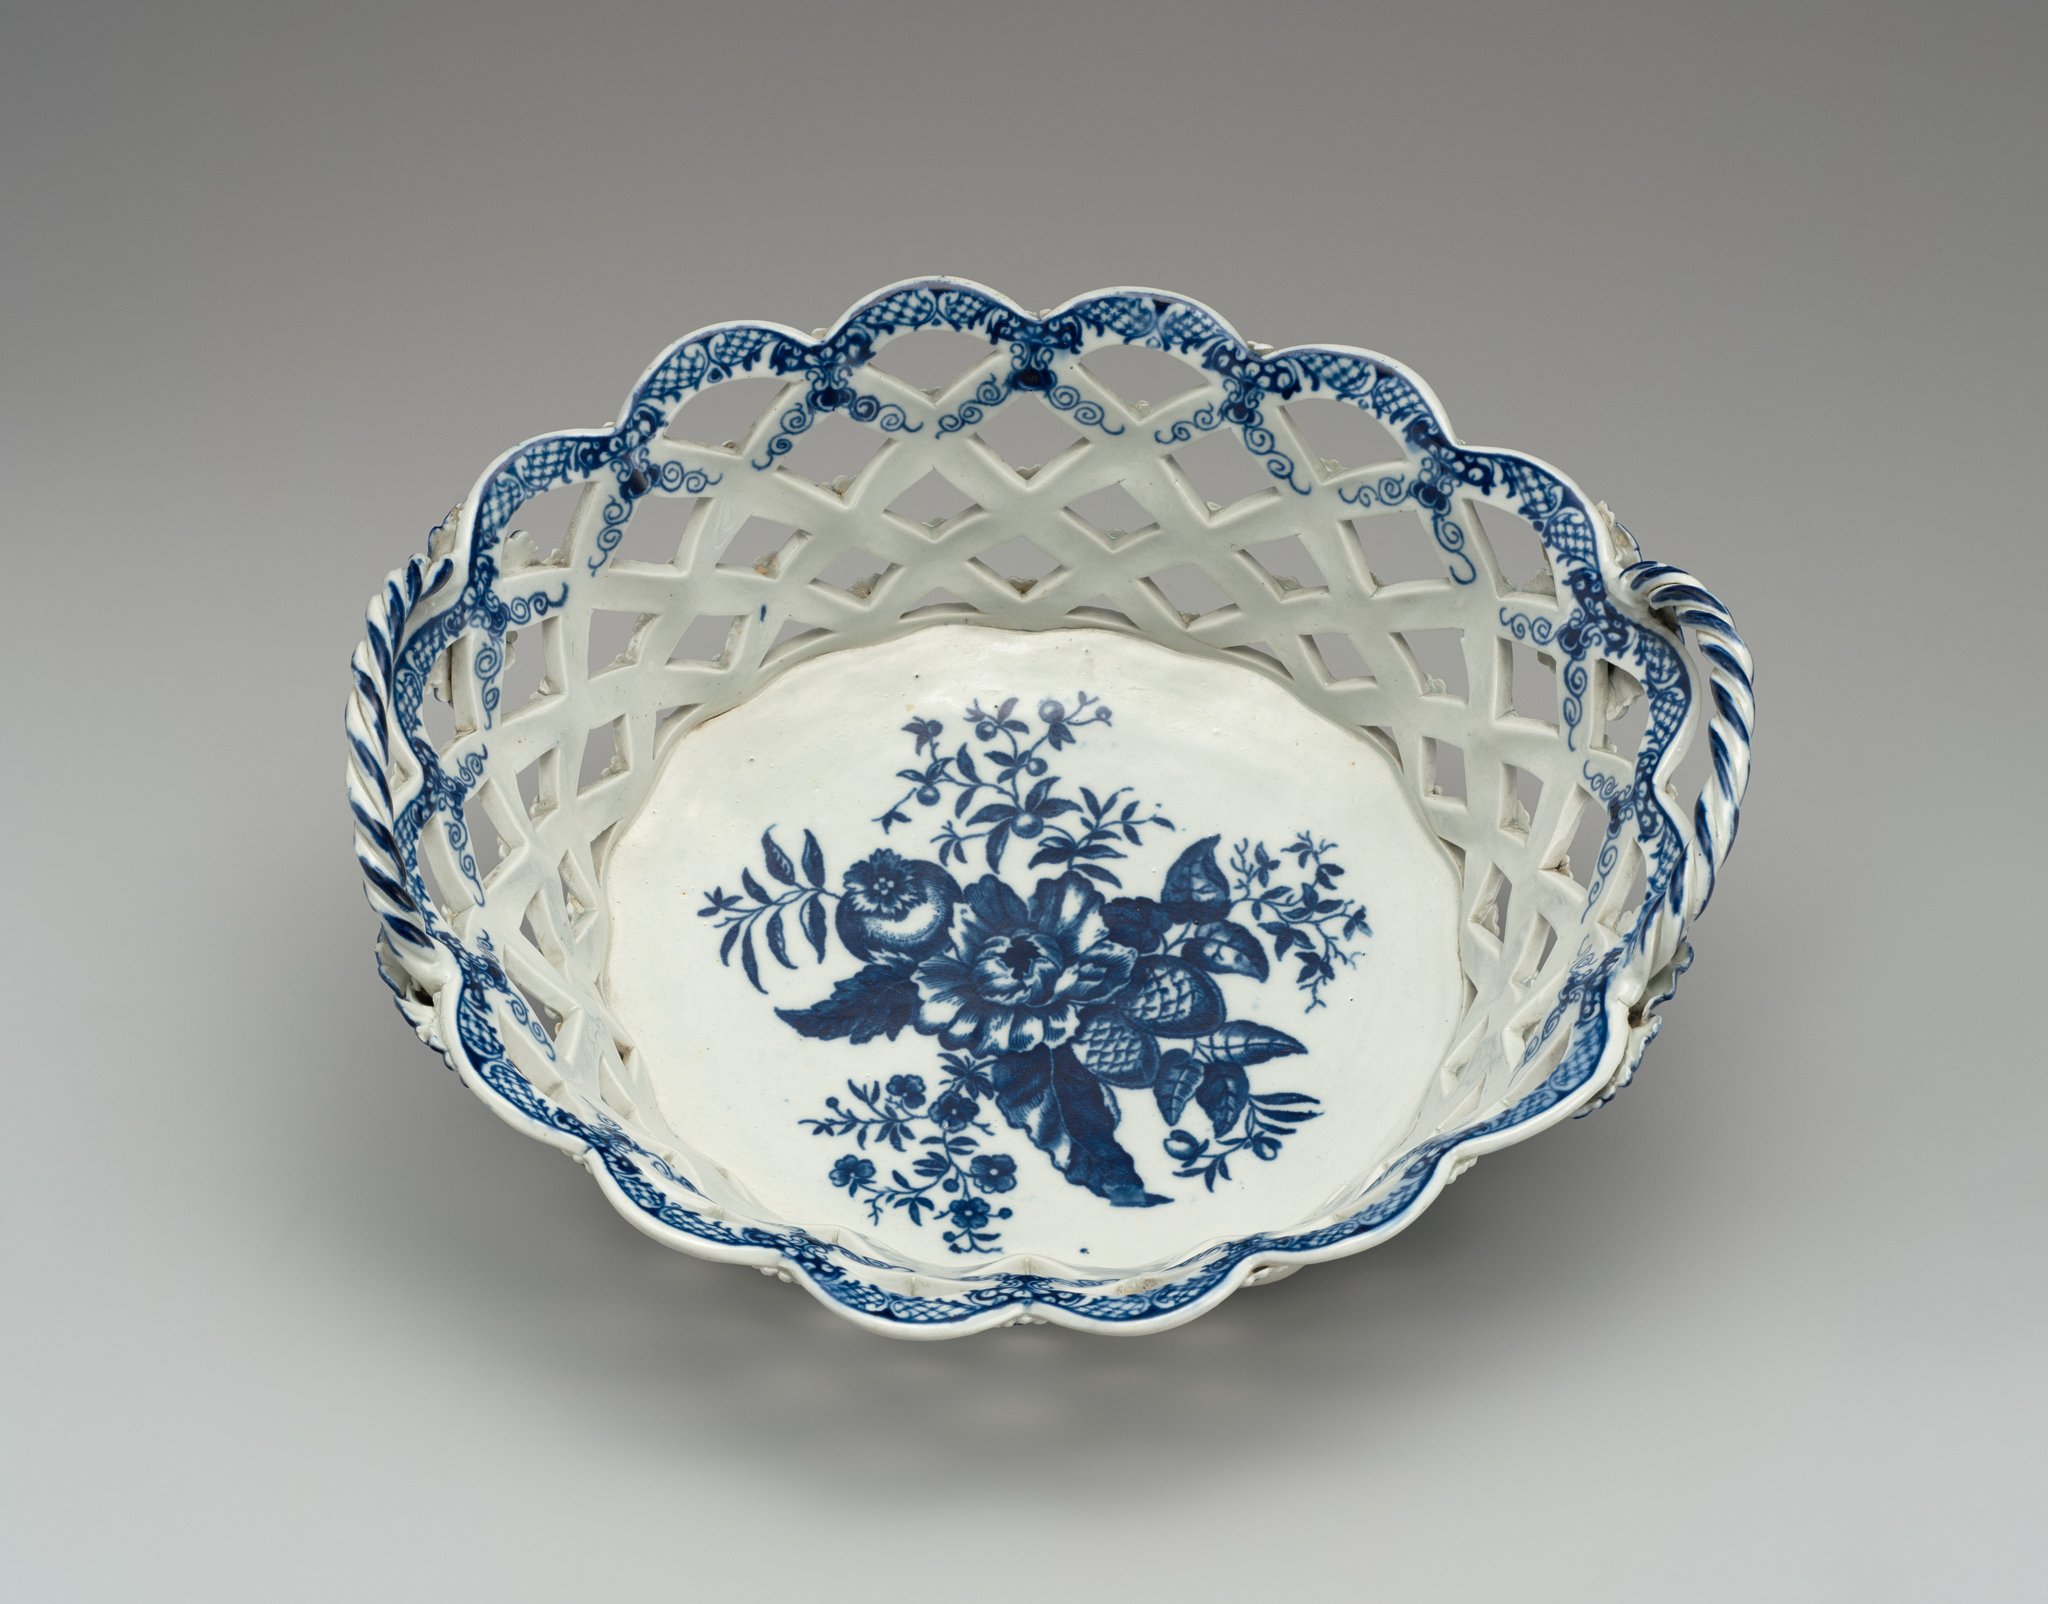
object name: dessert basket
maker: caughley factory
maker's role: factory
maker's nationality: british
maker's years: 1772-1799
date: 1775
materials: soft paste porcelain